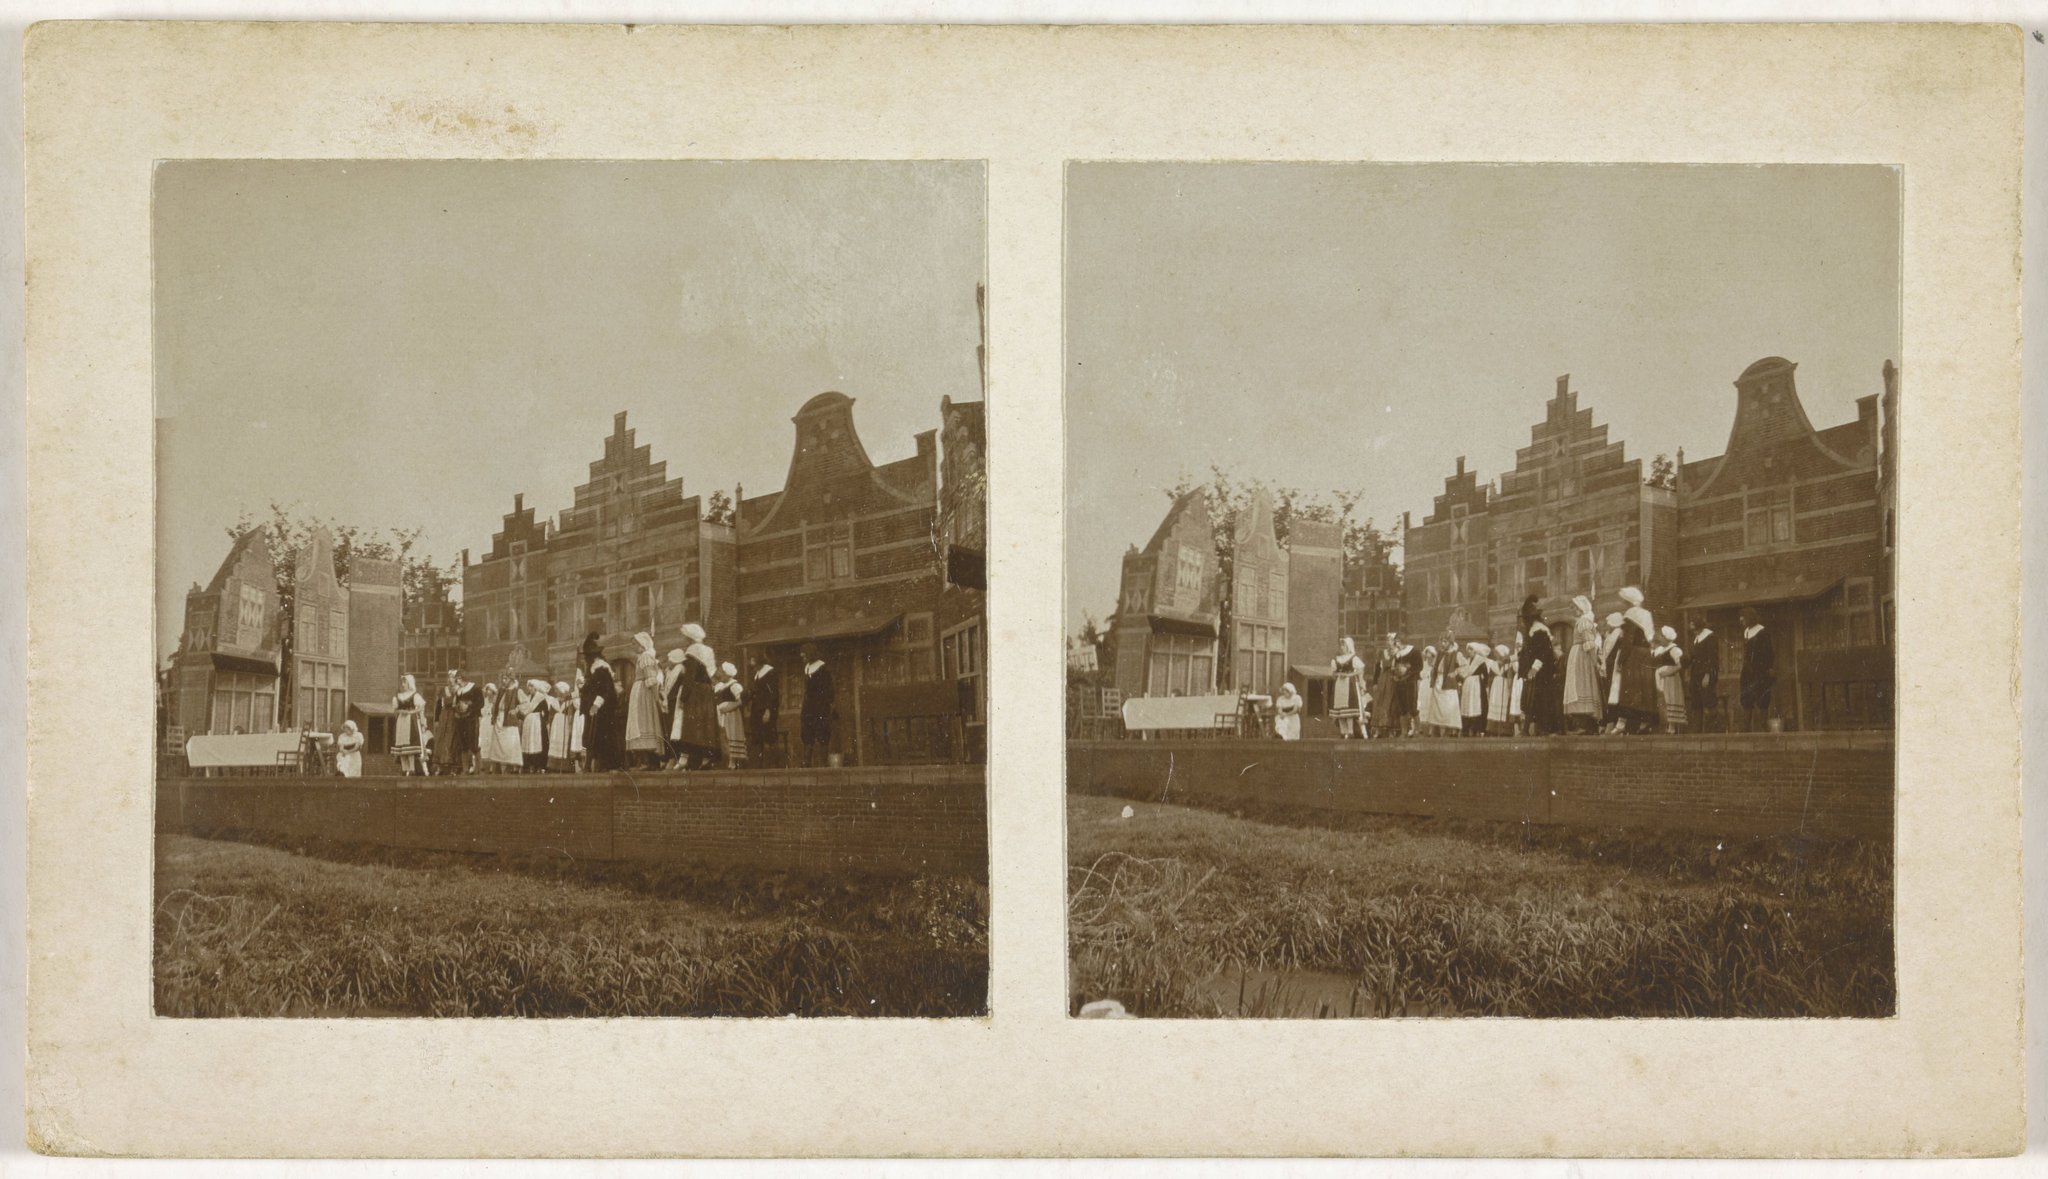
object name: stereograph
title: Opvoering van toneelstuk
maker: Anonymous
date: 1850-1920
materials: cardboard, paper, photographic support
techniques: gelatin silver print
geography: netherlands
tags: netherlands